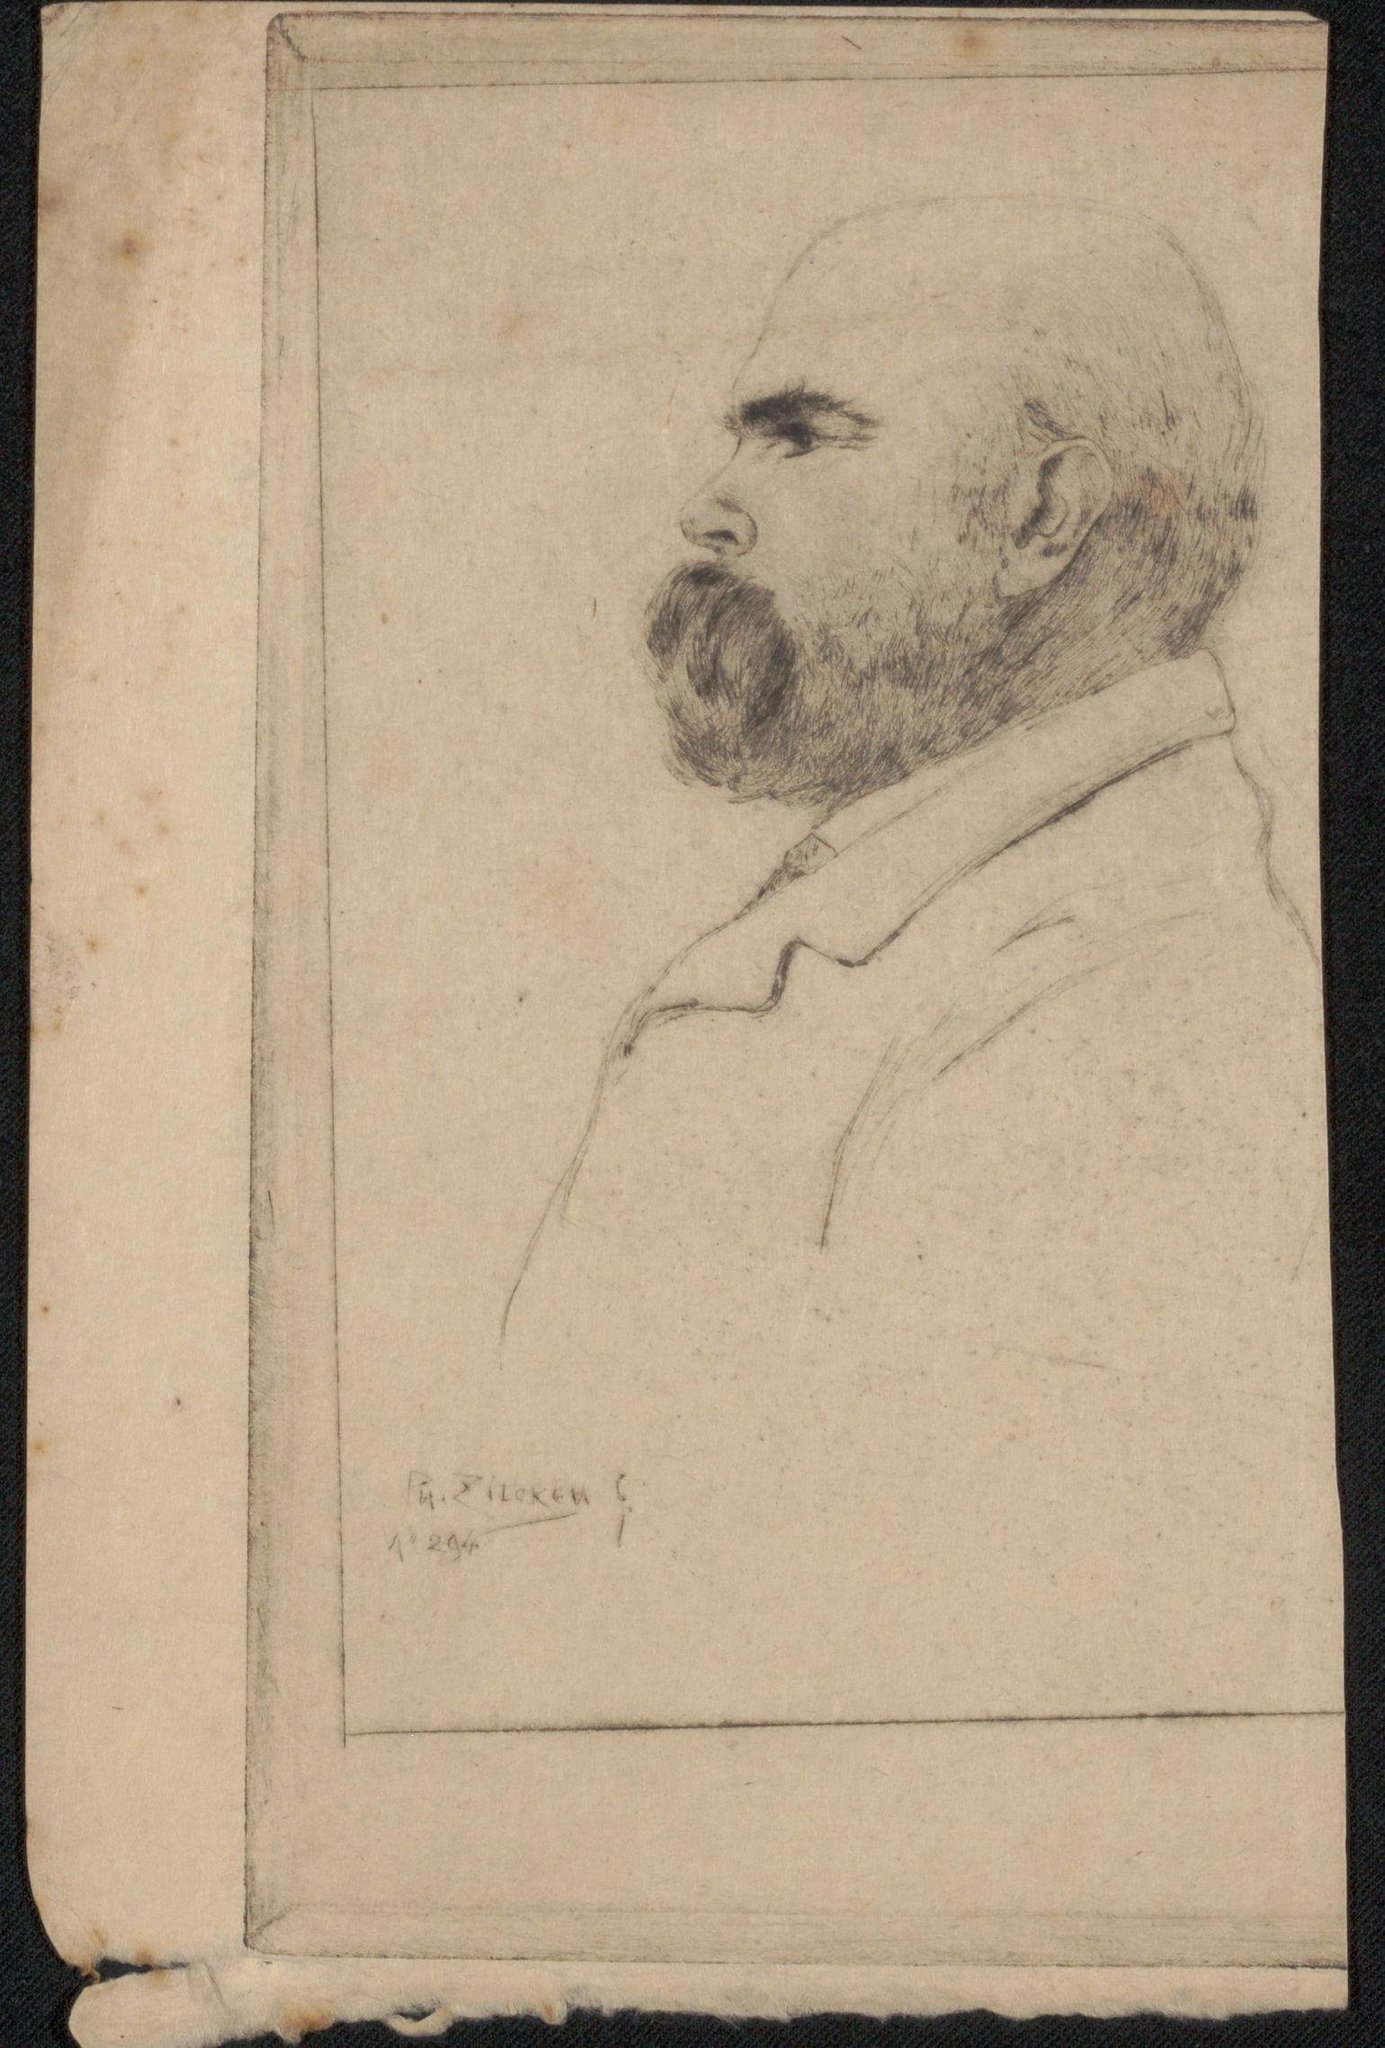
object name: print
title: Portret van Paul Verlaine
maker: philip zilcken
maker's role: draughtsman, painter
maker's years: 1857-1930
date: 1893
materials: paper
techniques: etching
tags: paris, paul verlaine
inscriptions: collector's mark: ‘RPK’